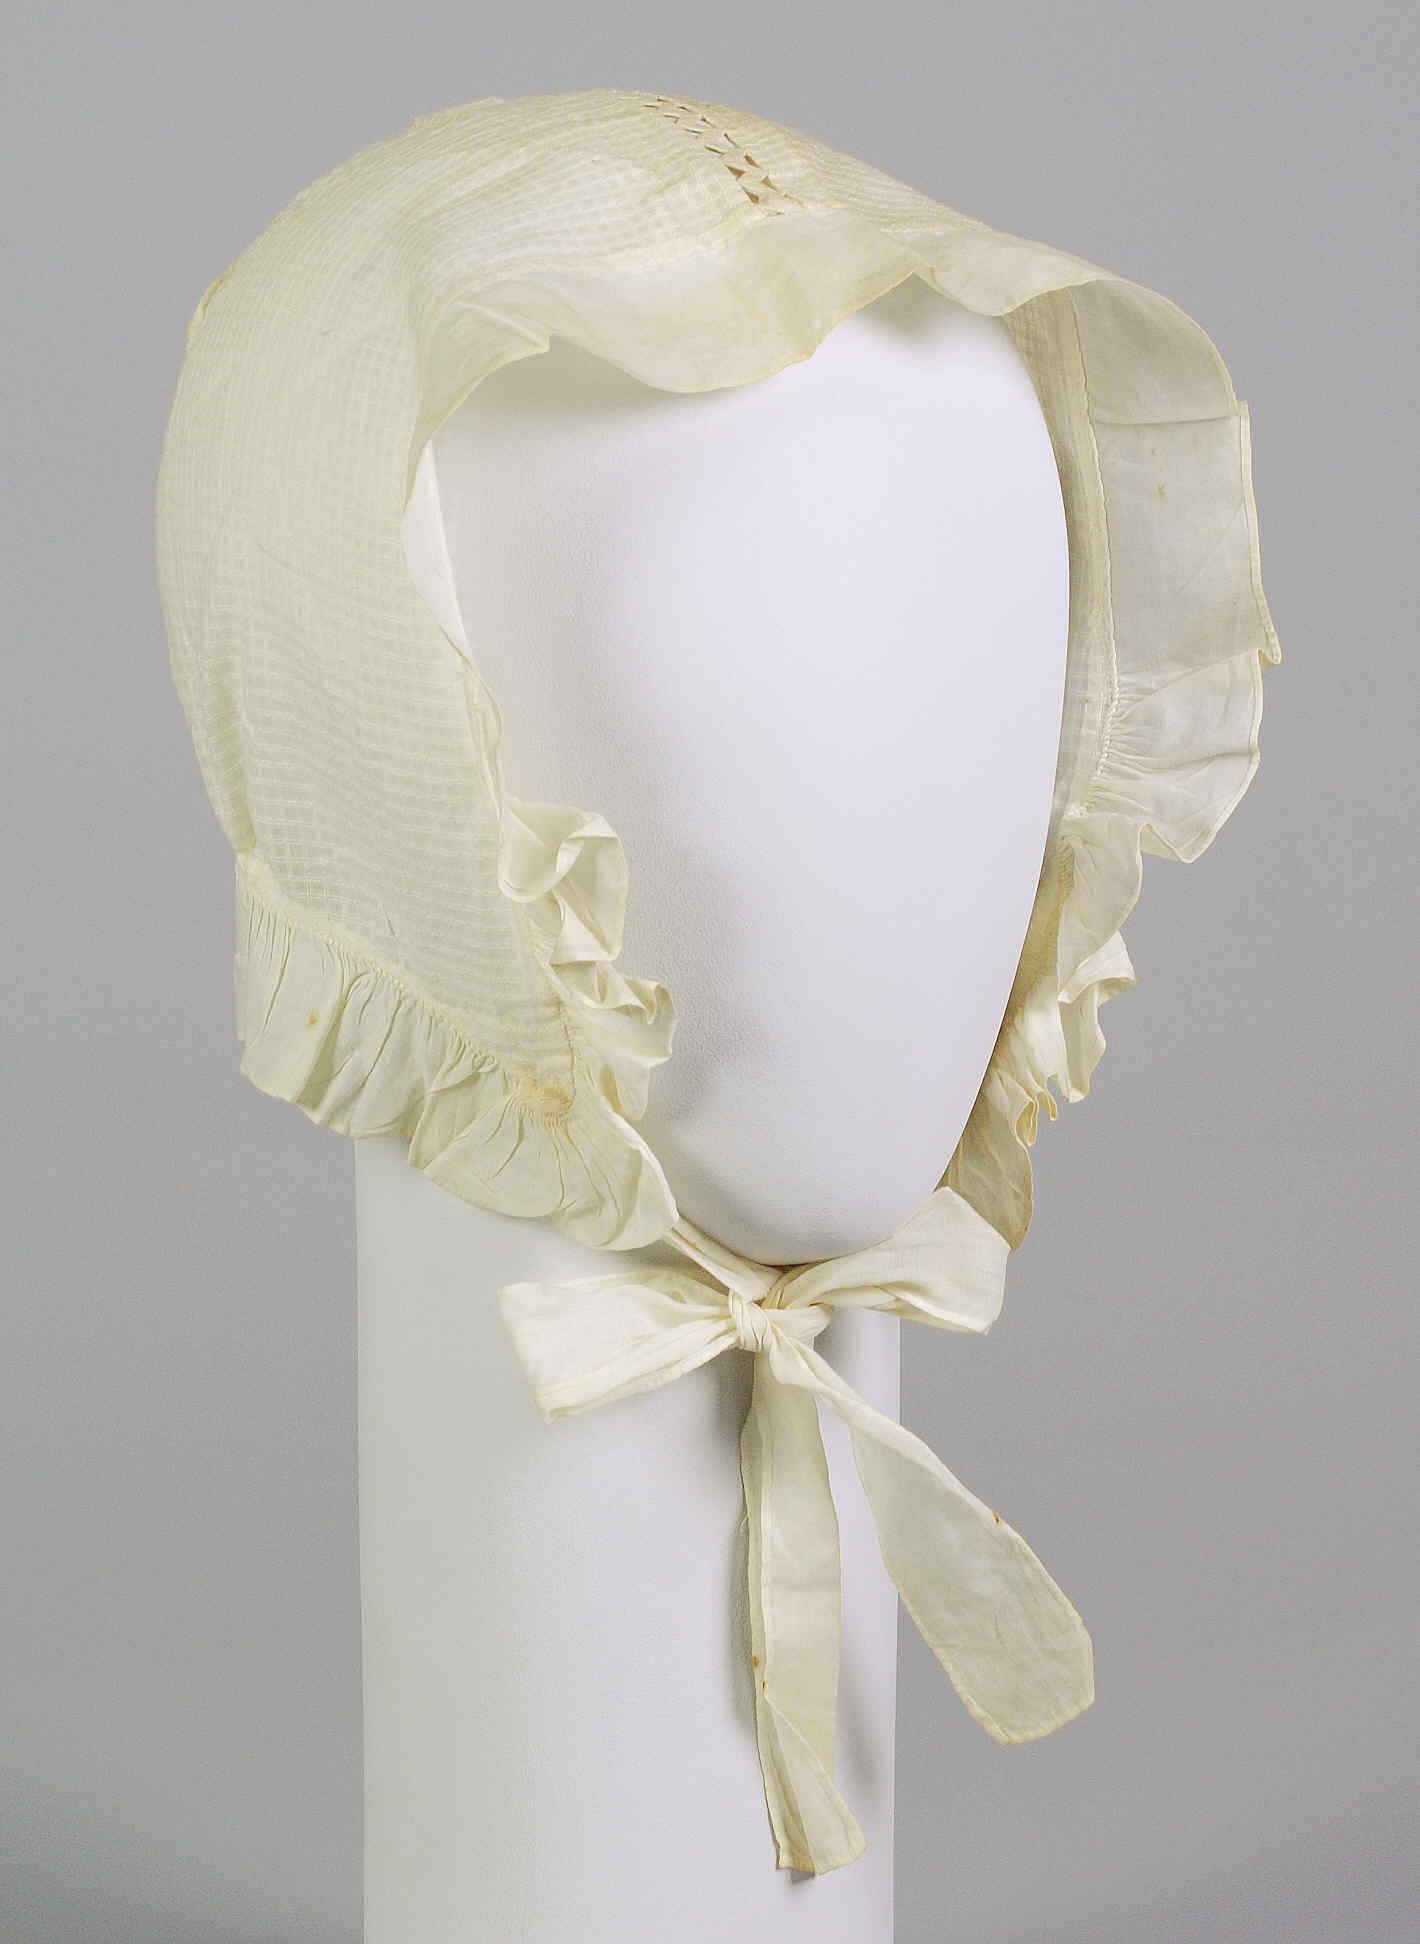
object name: cap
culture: american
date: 1840-1860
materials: cotton